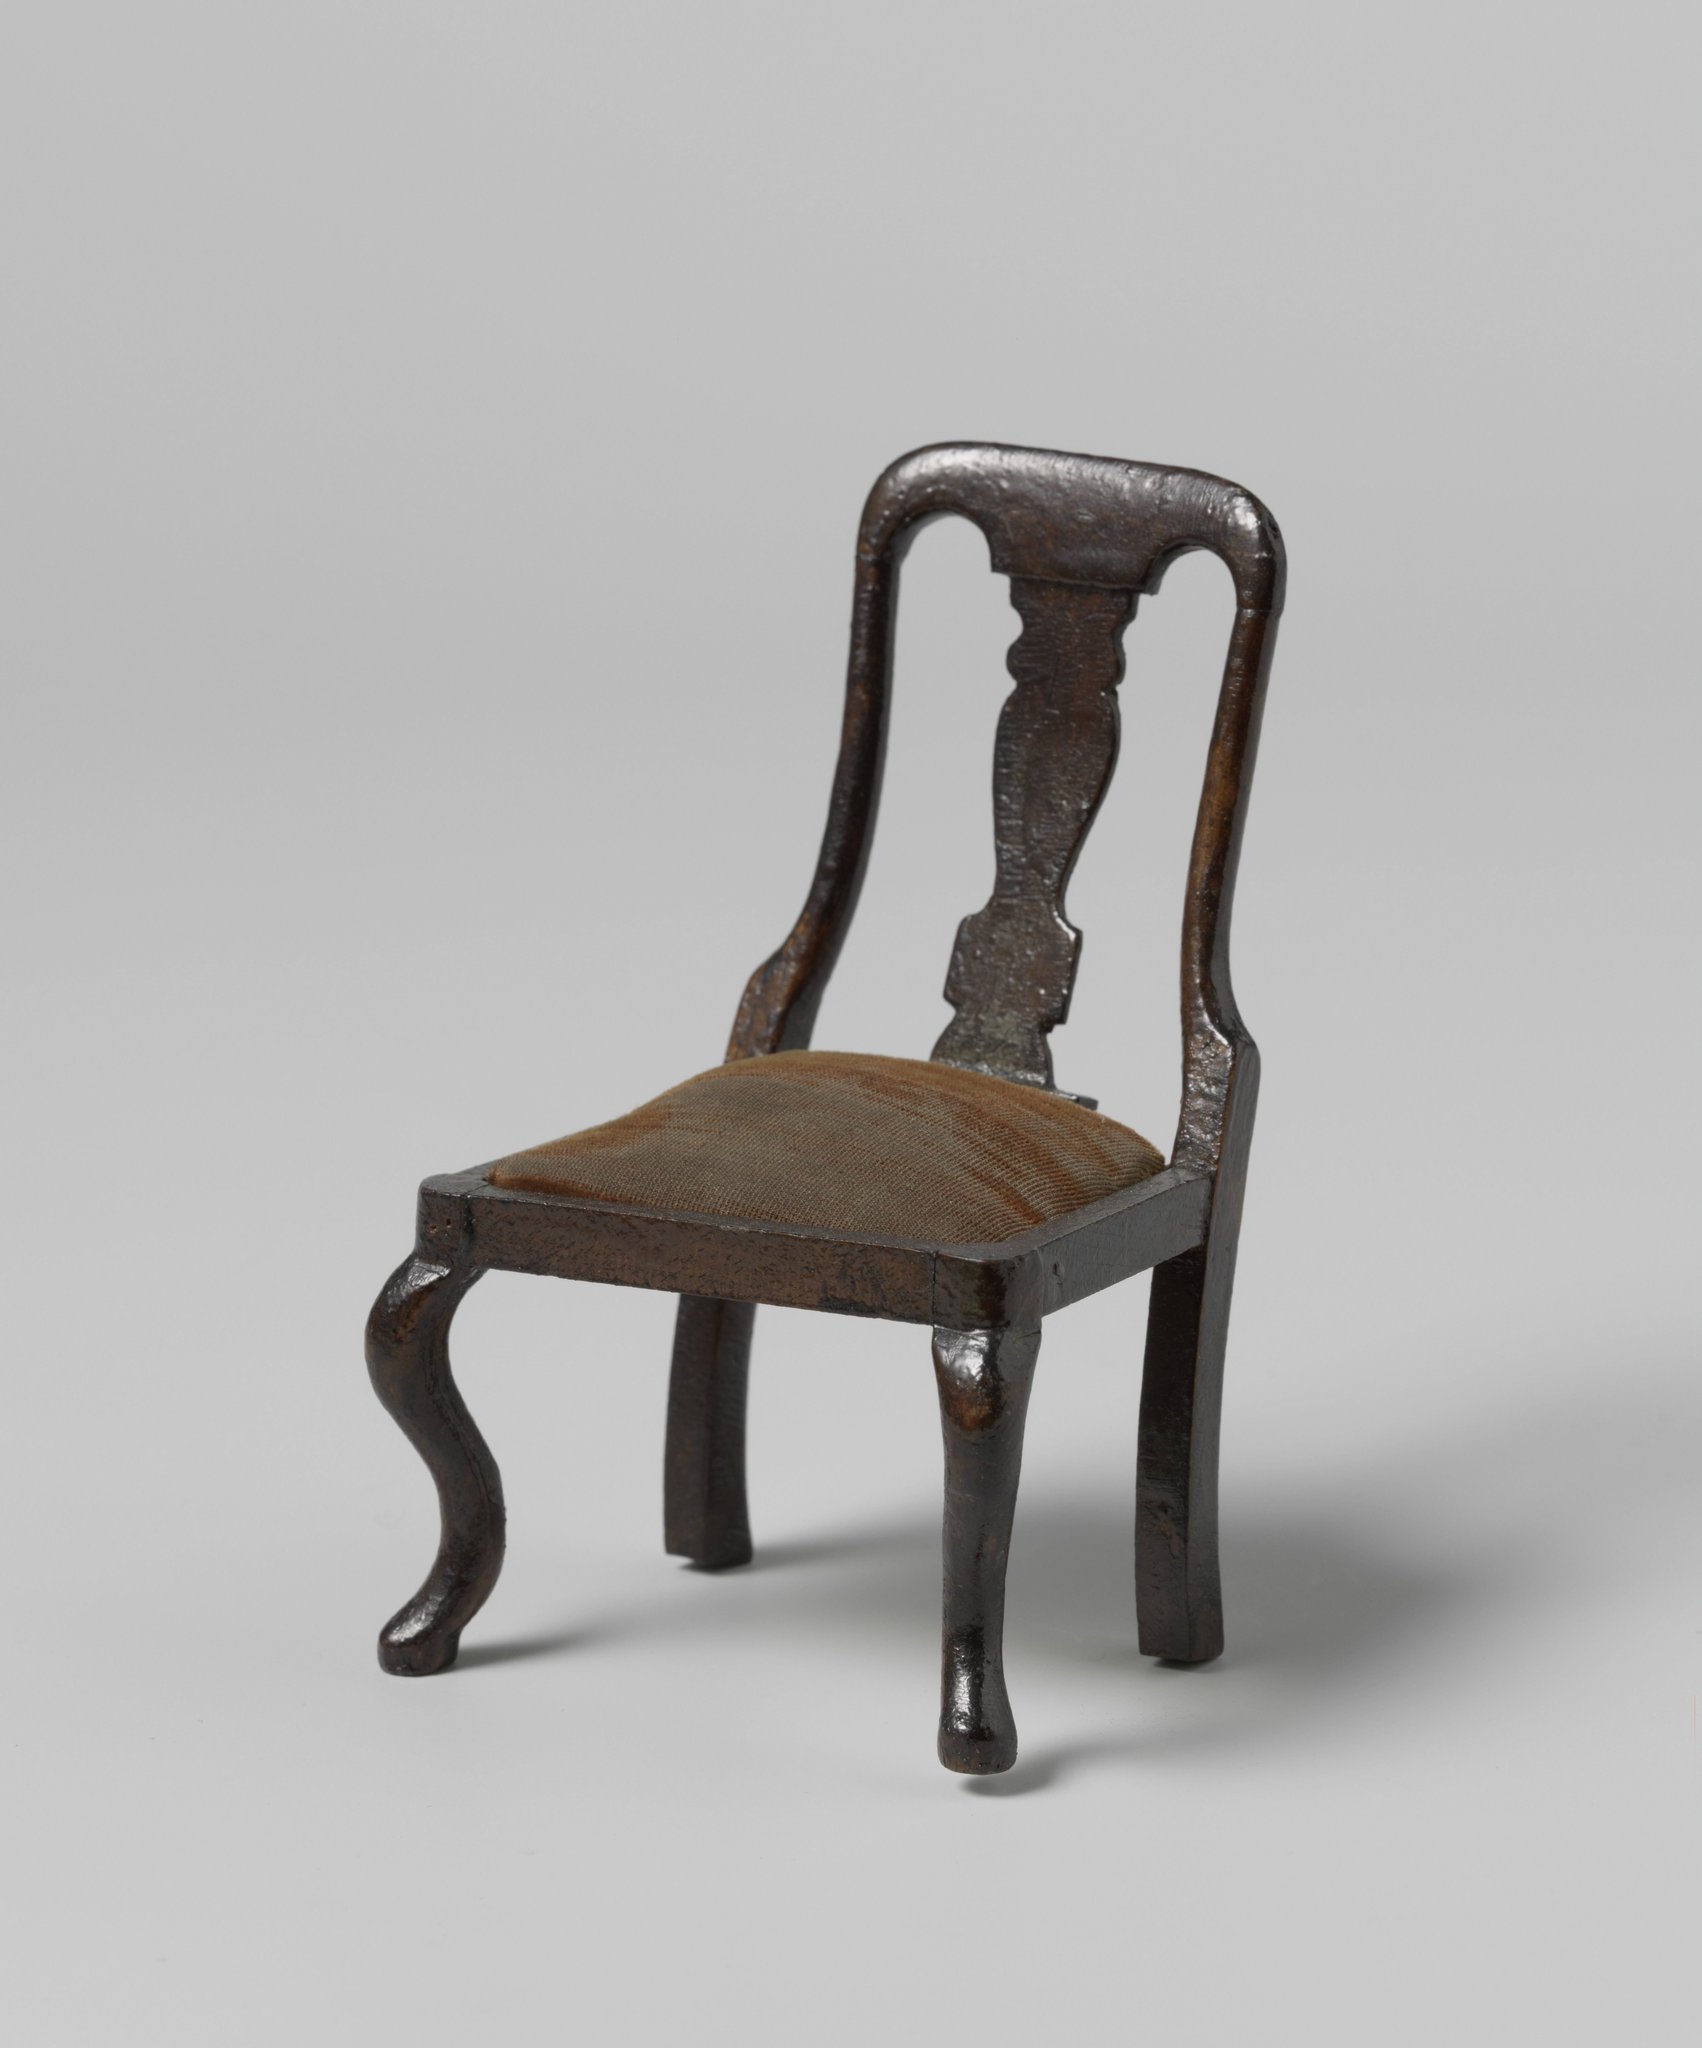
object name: miniature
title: Stoel, de rug met vaasvormig middenblad, de zitting met bordeauxrode fluweel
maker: Anonymous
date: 1800-1899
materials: wood, velvet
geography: amsterdam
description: Stoel van mahoniehout. De rug is open met een vaasvormig middenblad. De stoel heeft een trapezium-vormig open zitraam met losse zitting met bordeauxrode fluweel.